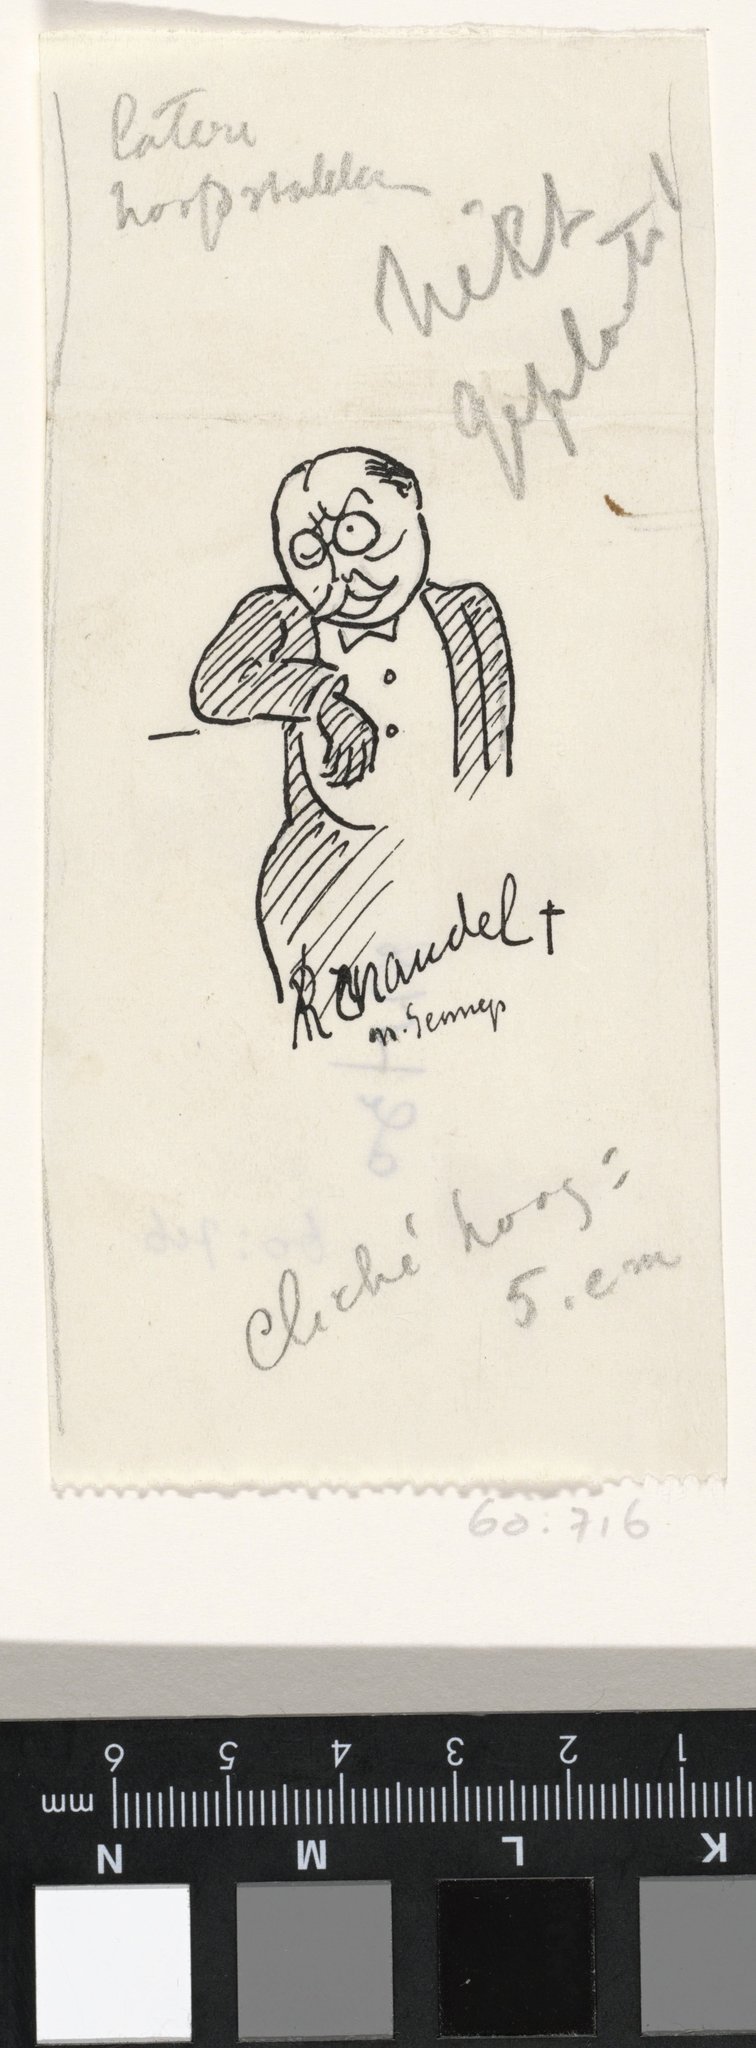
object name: boekillustratie ontwerp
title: Karikatuur van Pierre Renaudel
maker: leo gestel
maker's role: draughtsman, print maker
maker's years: 1881-1941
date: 1934-1936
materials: ink, paper, pencil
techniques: pen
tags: politician, (cohen, van anarchist tot monarchist) specific works of literature (with author, title)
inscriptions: clichéaanwijzing, recto, handgeschreven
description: Ontwerp voor een boekillustratie voor: Cohen, Alexander. Van anarchist tot monarchist. Amsterdam: De Steenuil, 1936.